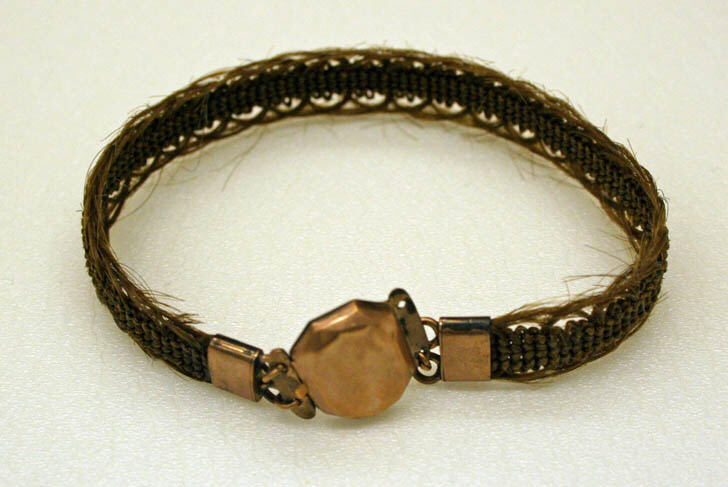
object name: bracelet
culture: american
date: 1850-1875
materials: hair, metal